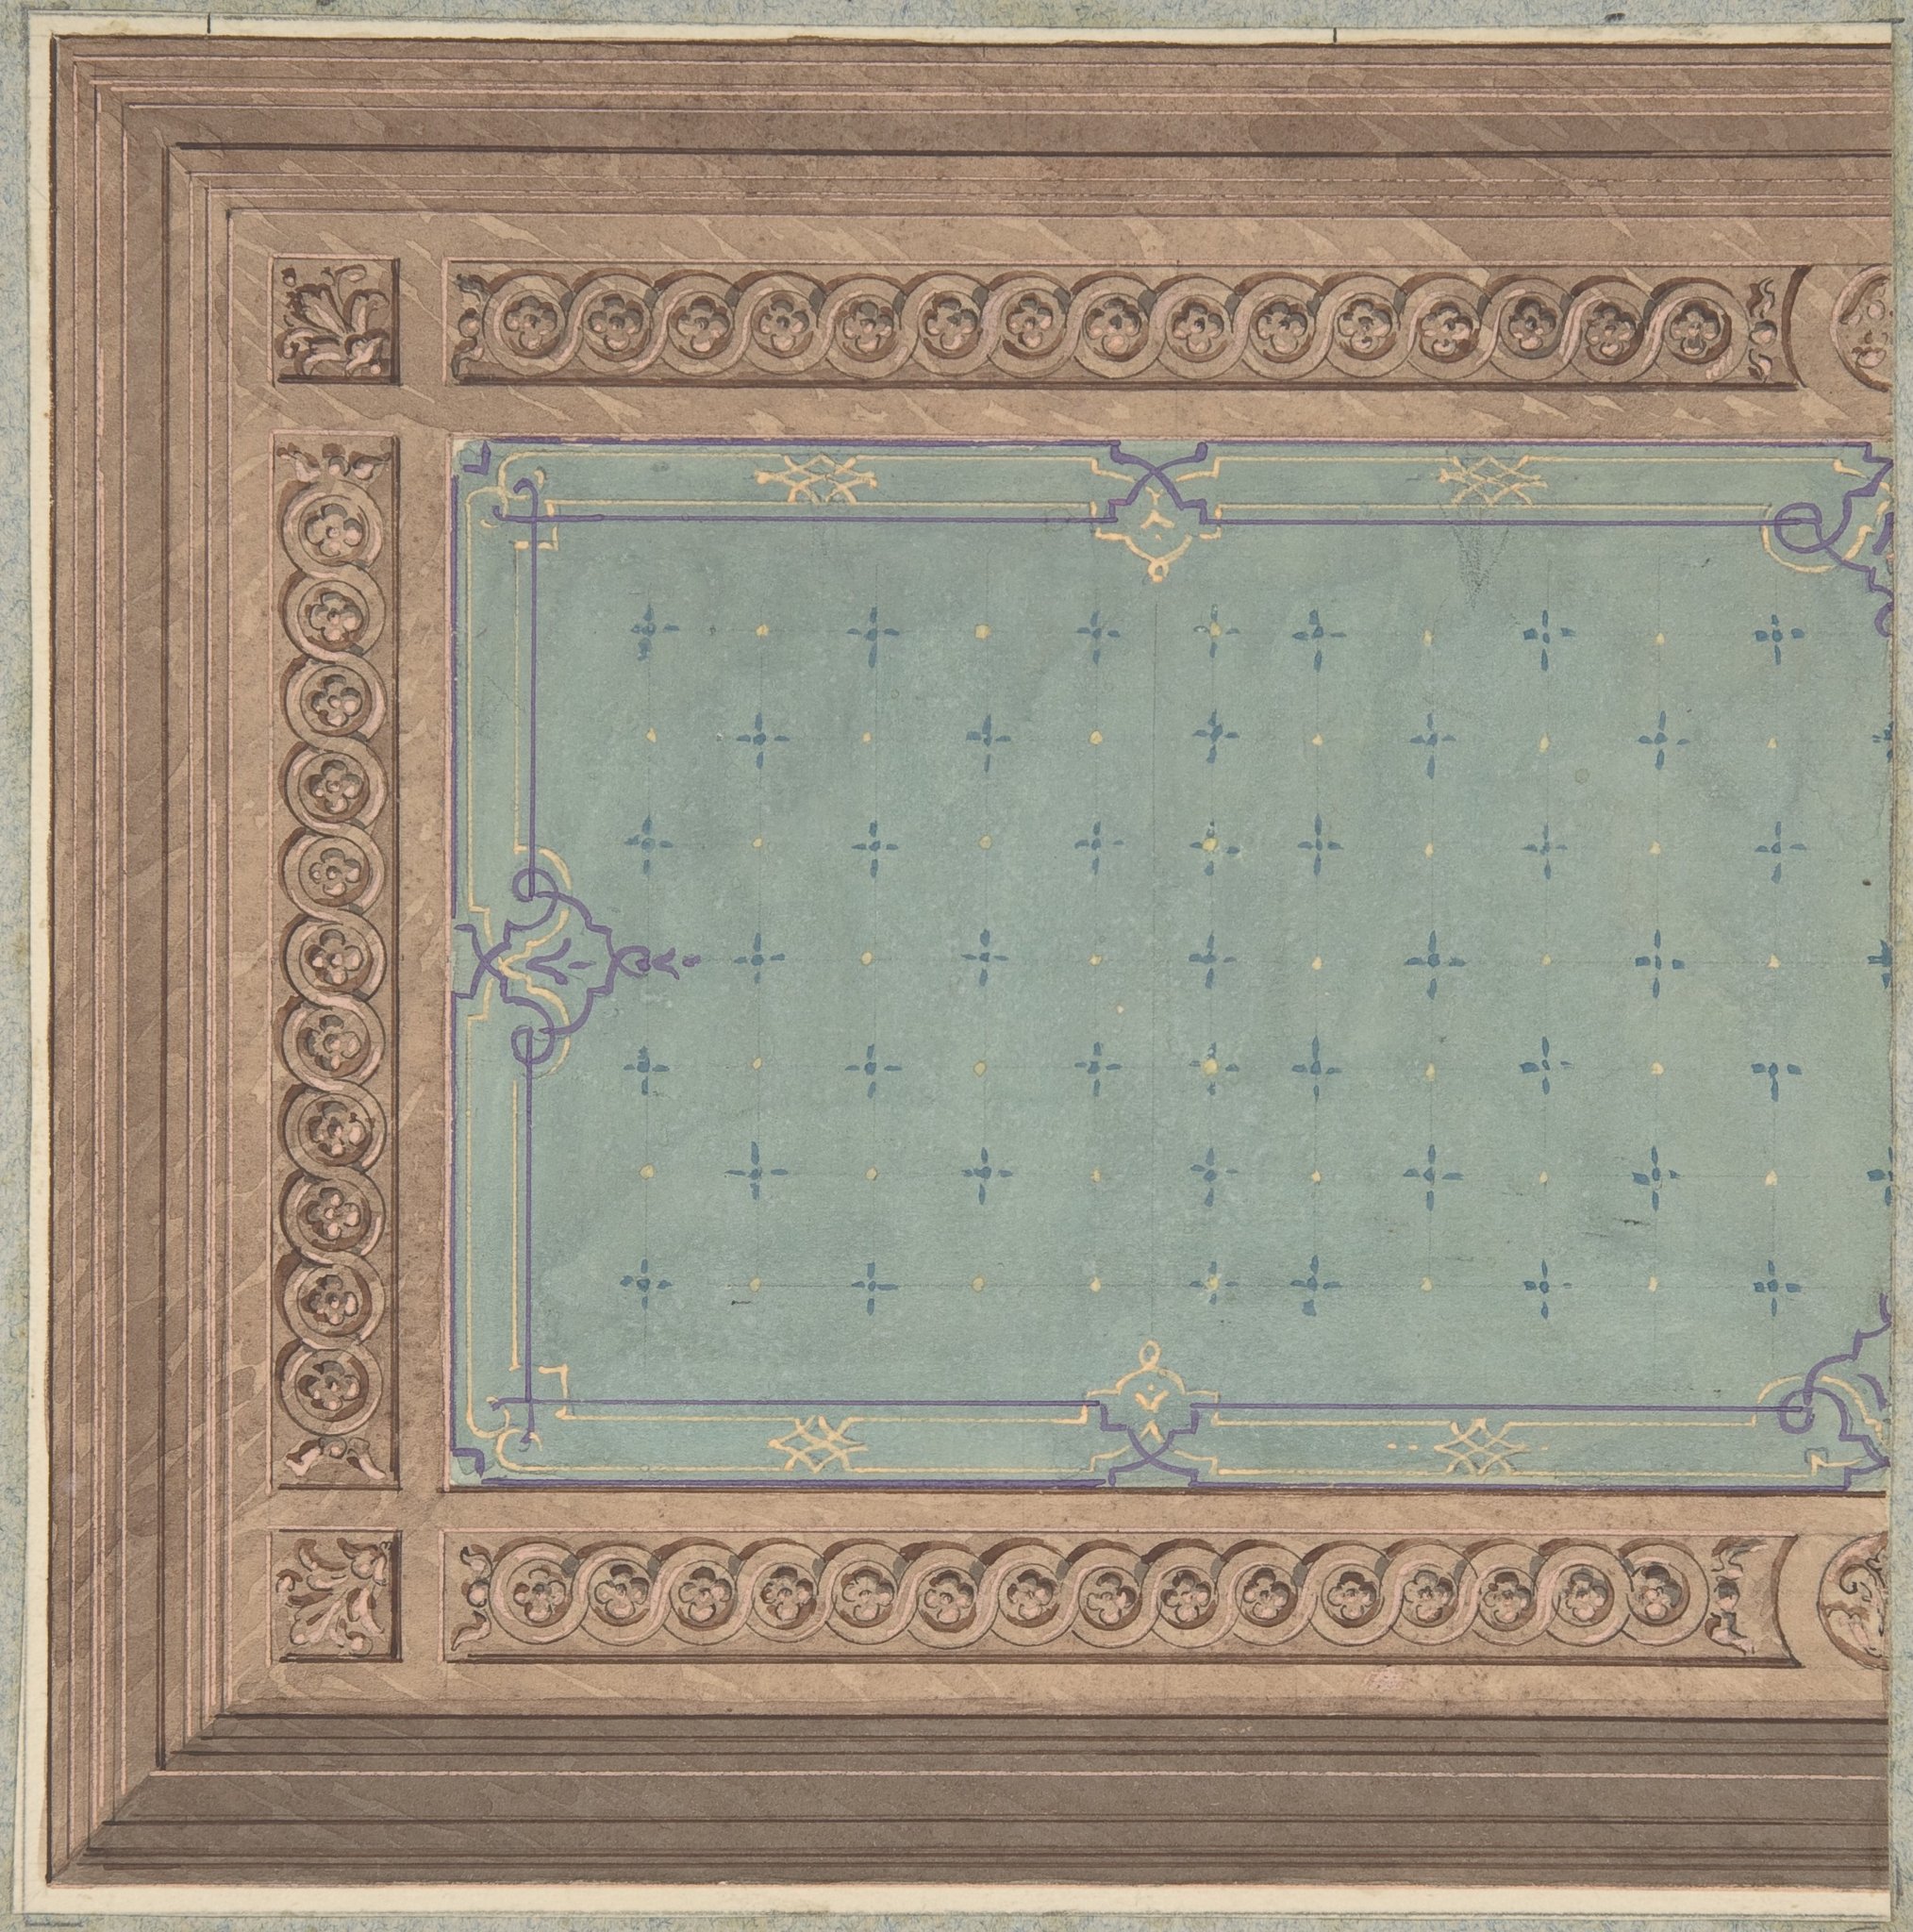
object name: drawing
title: Design for Ceiling, Hôtel de Boivin, Paris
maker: jules-edmond-charles lachaise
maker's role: artist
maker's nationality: french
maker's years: 1897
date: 1851-1900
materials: ink, watercolor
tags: ceilings